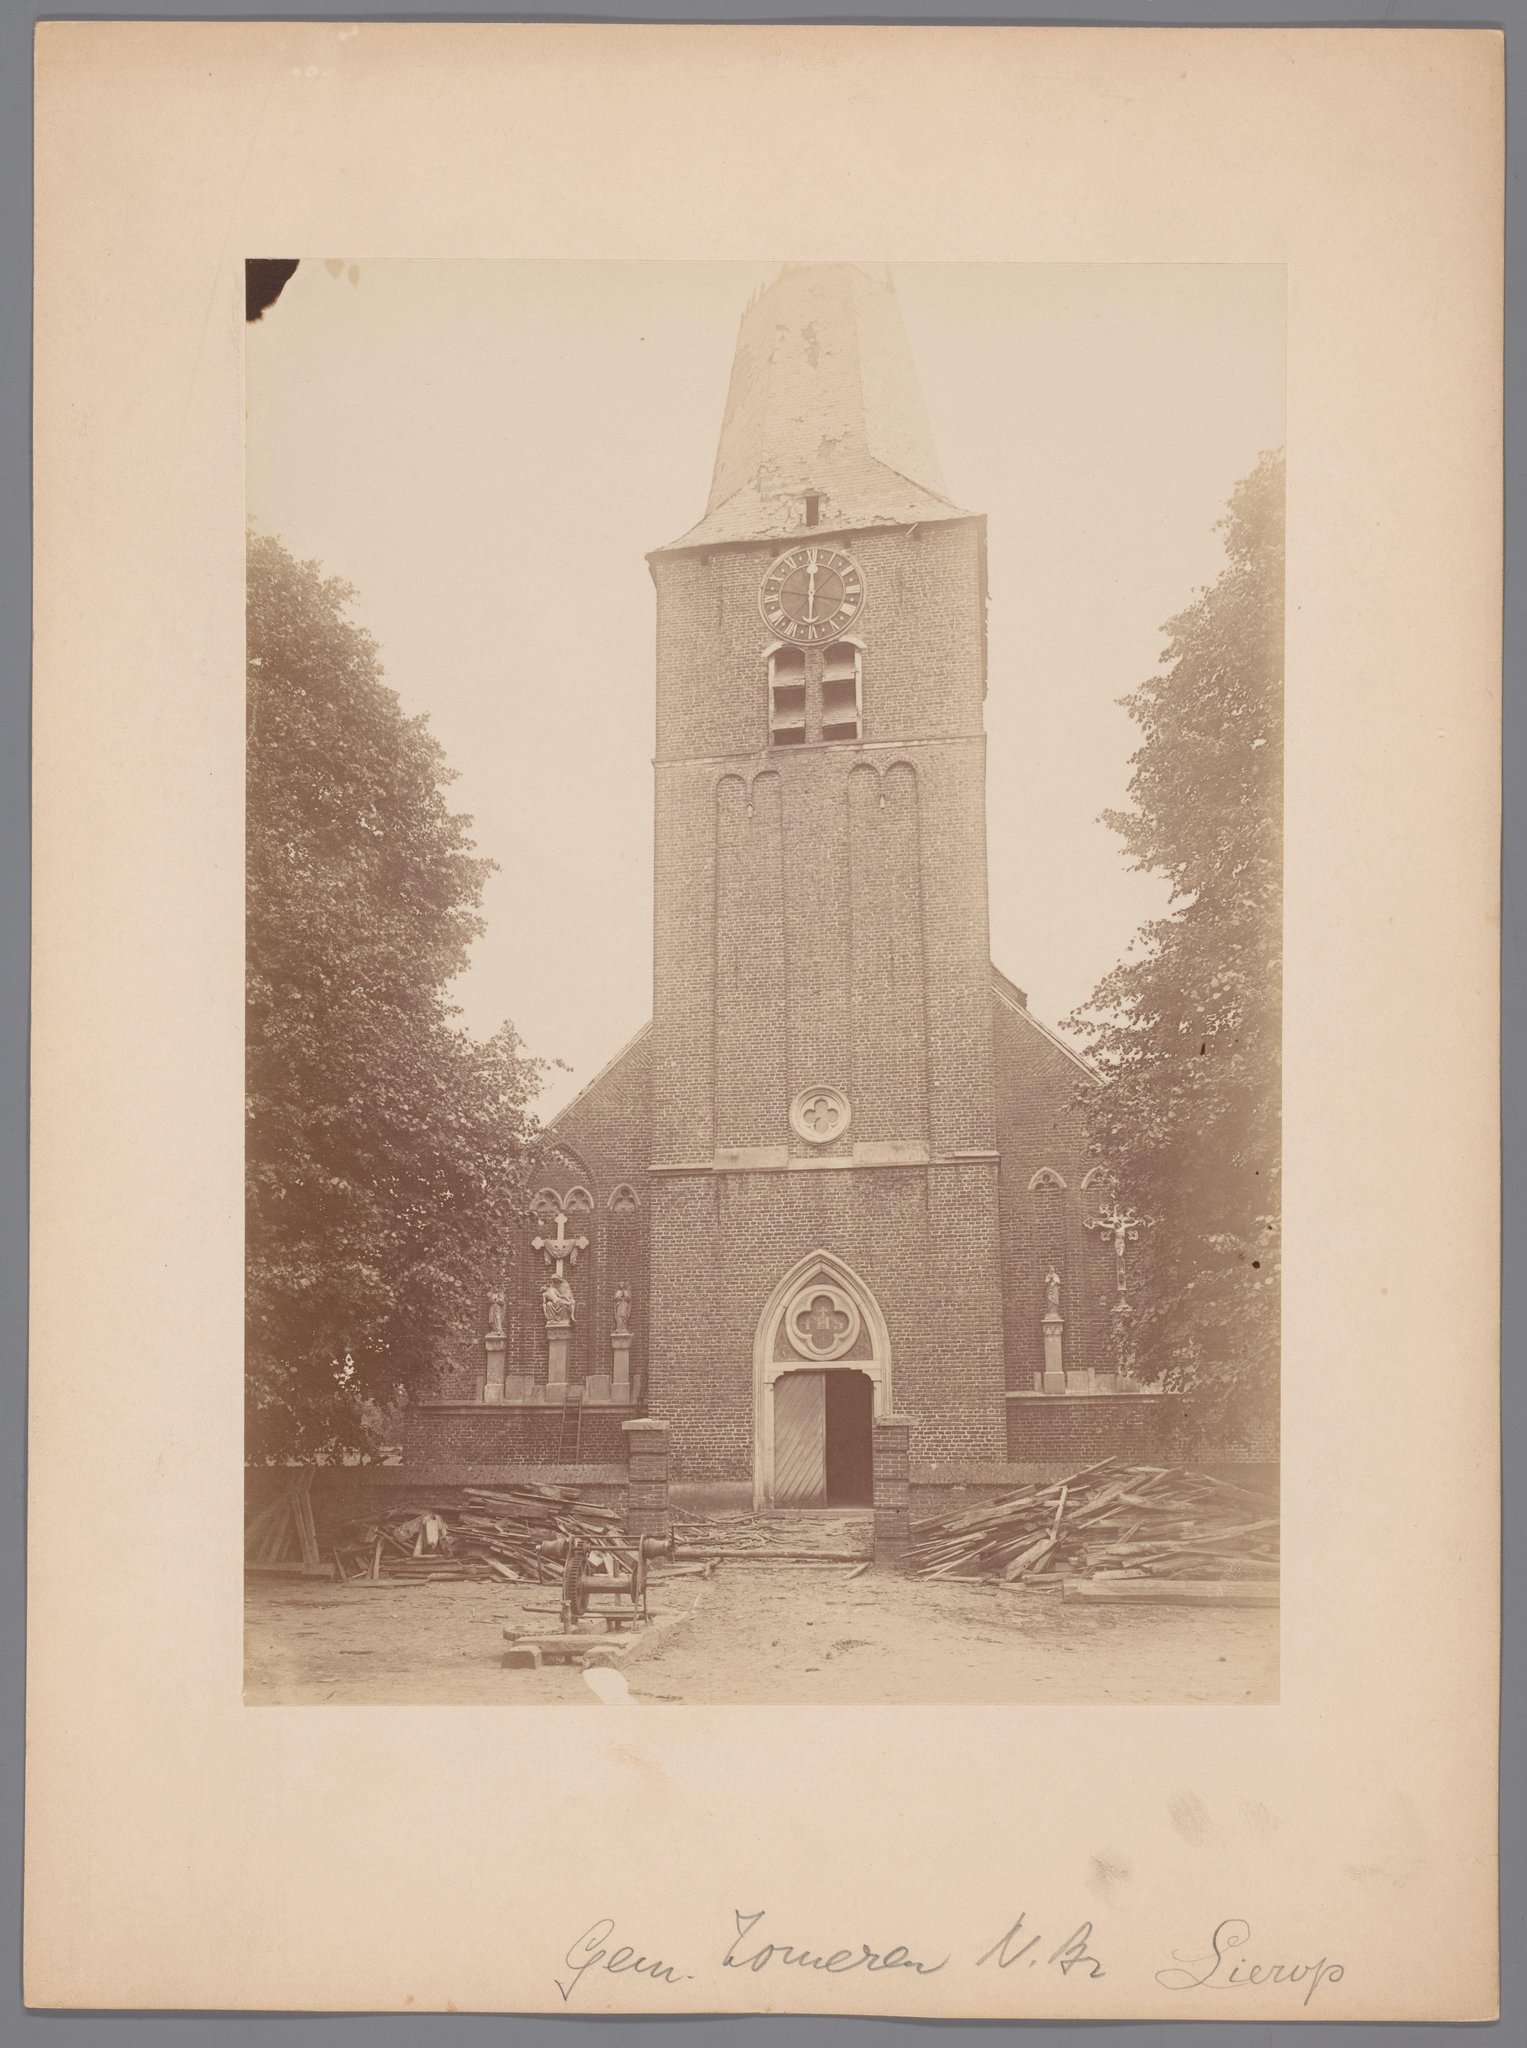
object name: photograph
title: Toren van de Rooms-Katholieke kerk te Lierop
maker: anoniem (monumentenzorg)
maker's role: fotograaf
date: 1891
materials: cardboard, photographic support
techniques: albumen print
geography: lierop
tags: parts of church exterior and annexes: tower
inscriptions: annotation: ‘Gem. Zomeren N.Br. Lierop’, annotation: ‘Westzijde v/d R.K. Kerk te Lierop bij Helmond/ Juli 1891’